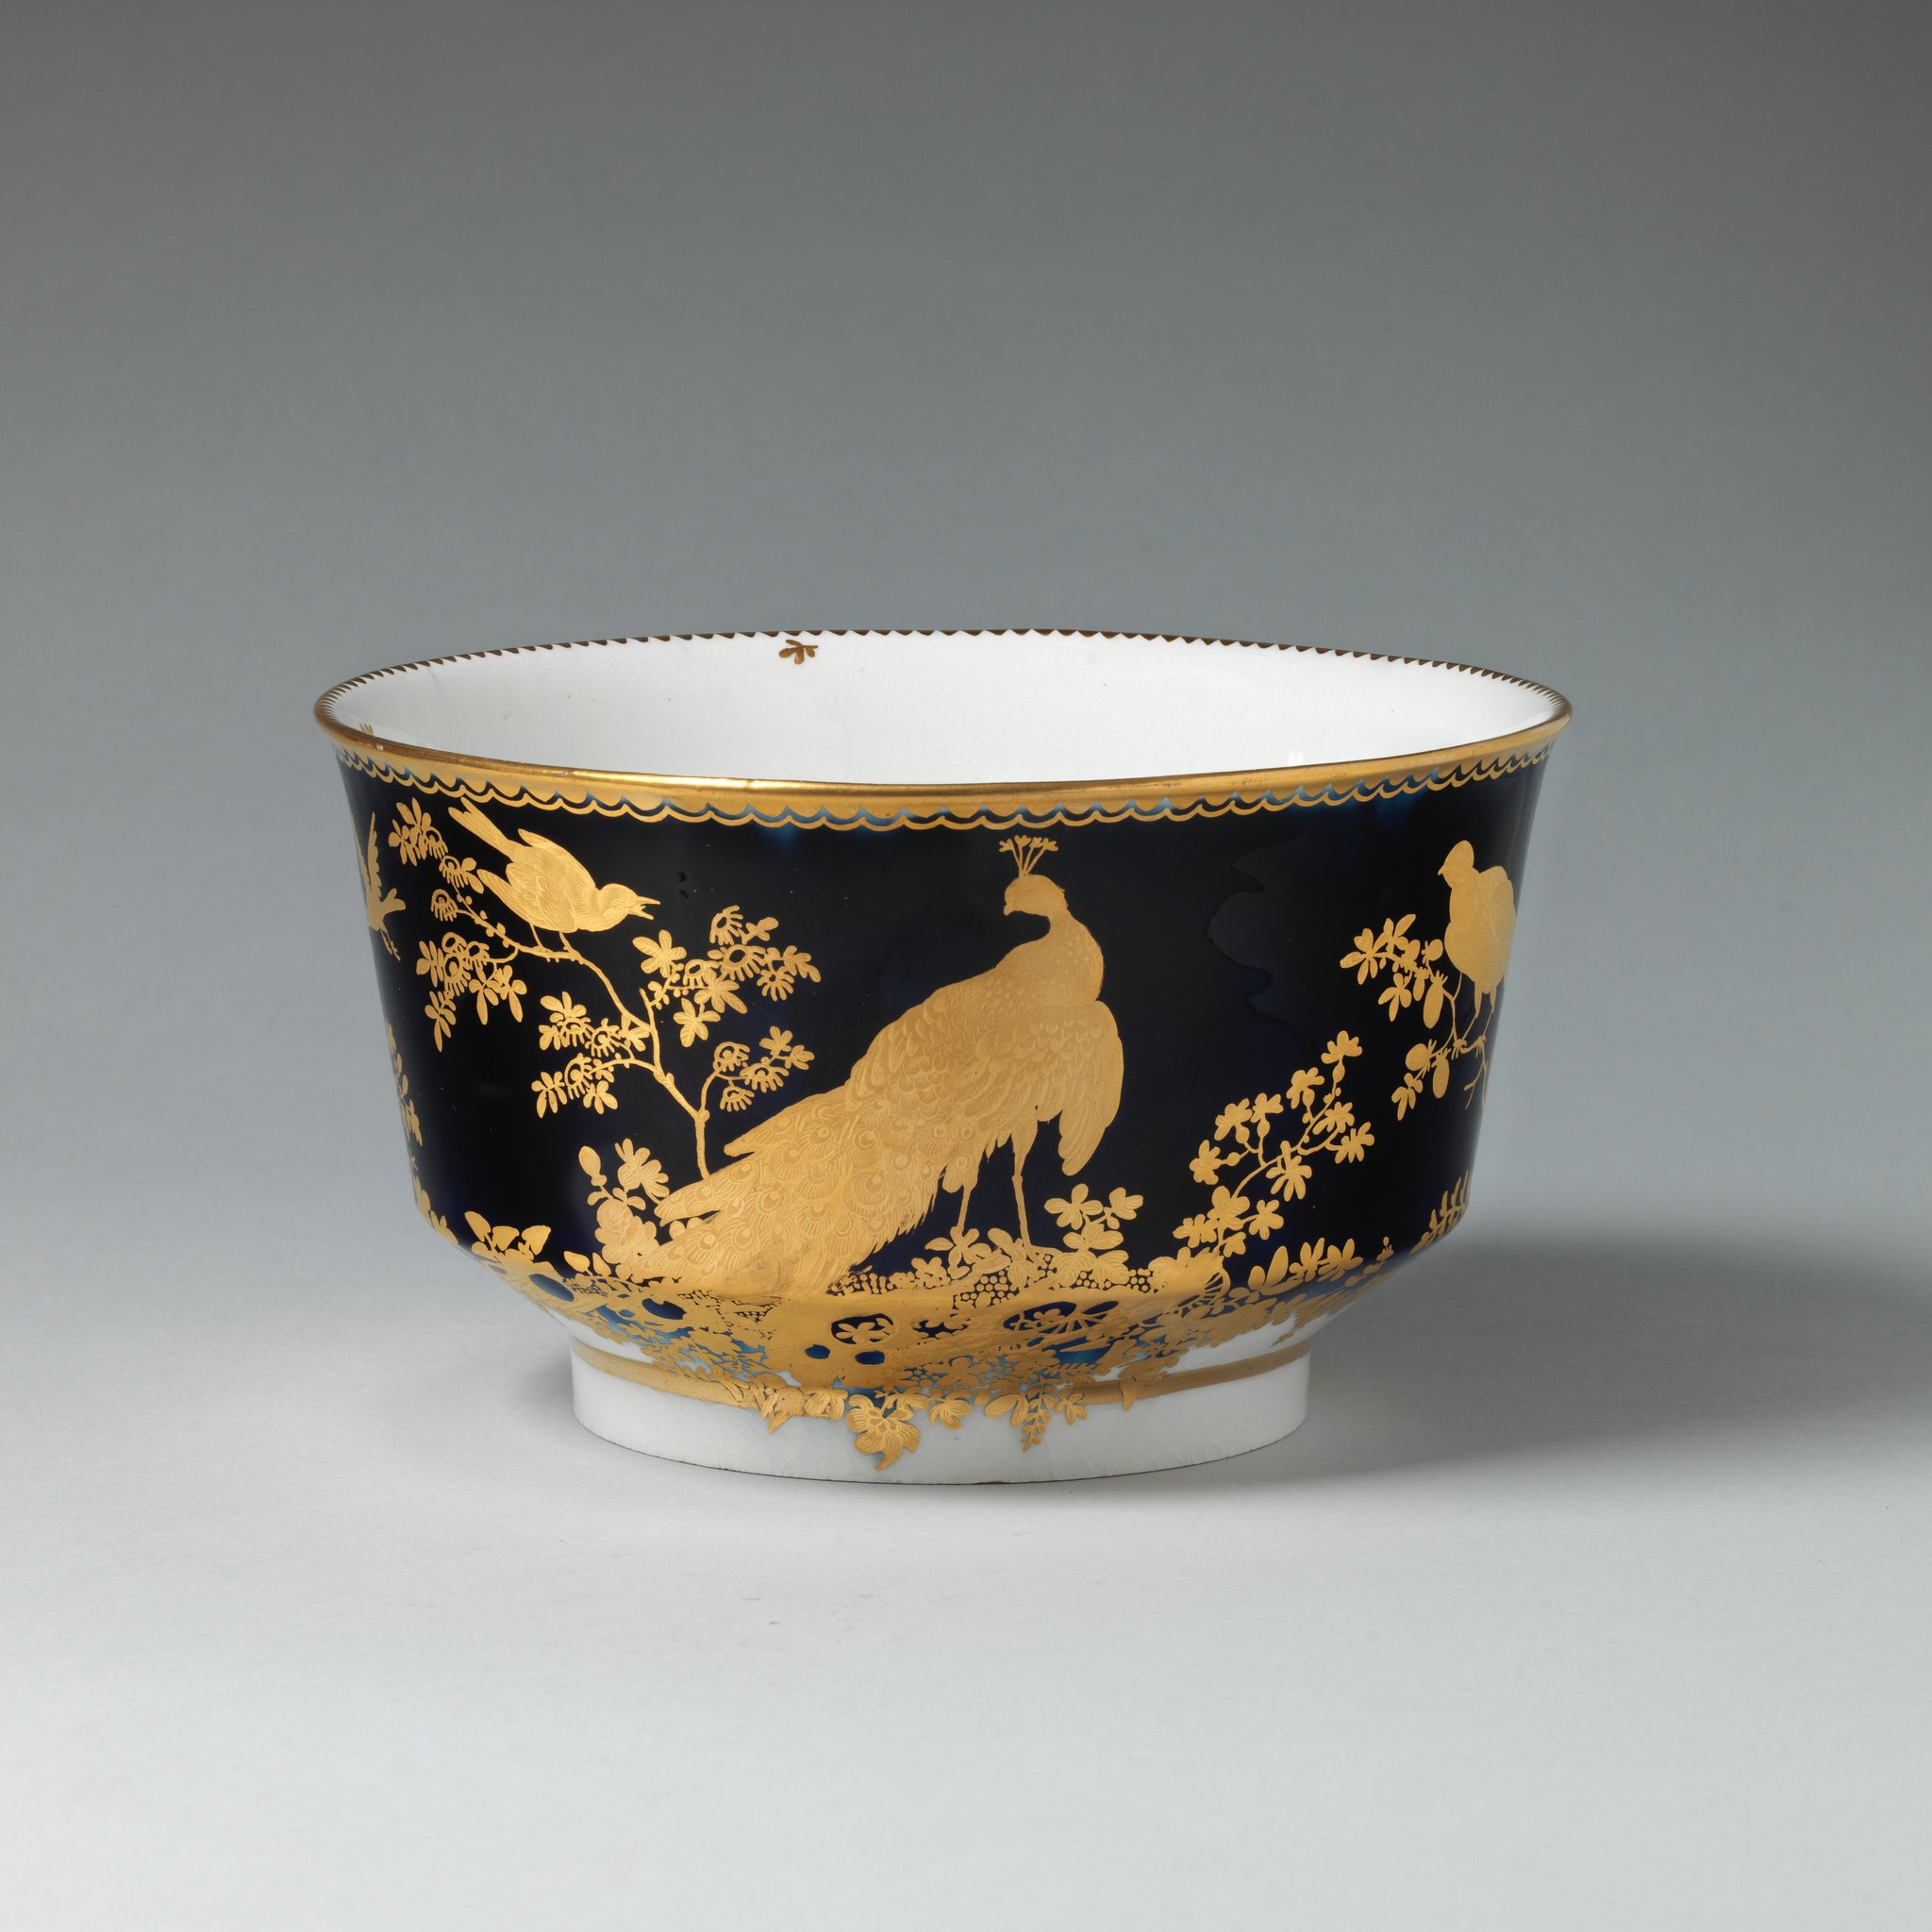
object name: cake bowl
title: Cake bowl (part of a service)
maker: chelsea porcelain manufactory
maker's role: factory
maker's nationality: british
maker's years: 1744-1784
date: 1758-1769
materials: soft paste porcelain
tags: peacocks,trees